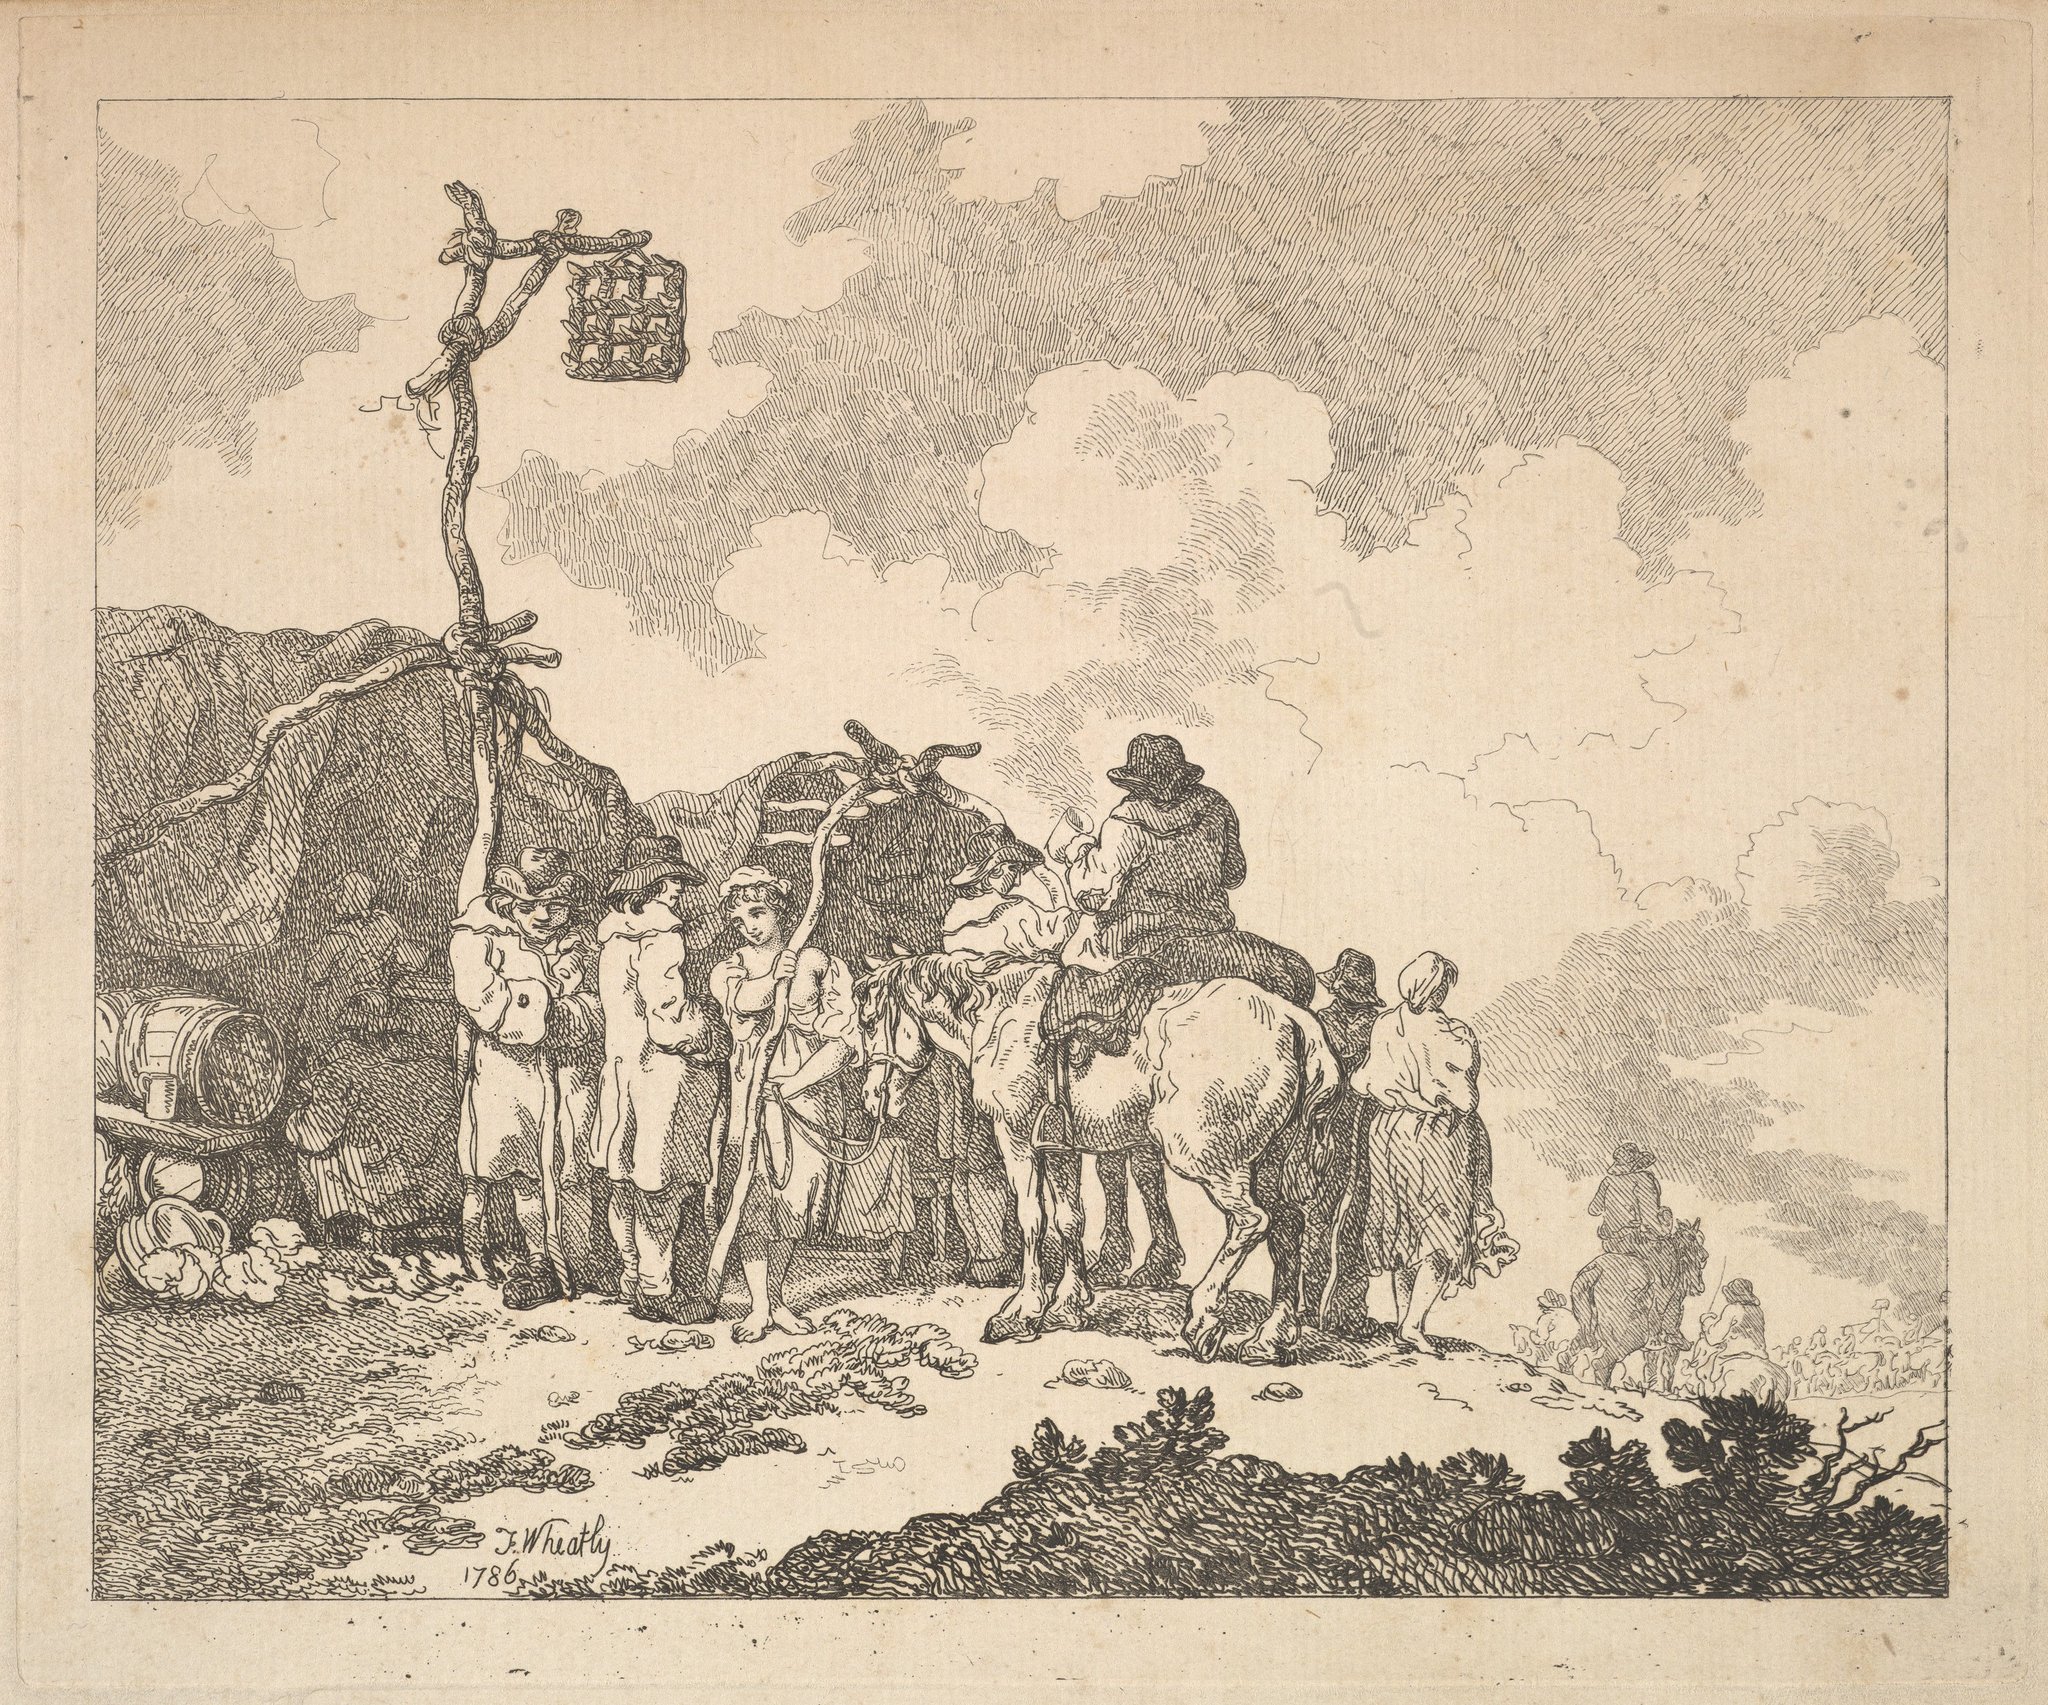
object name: print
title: A Fair – A Group of Gypsies – Men and Women in Rustic Clothes in Front of Two Makeshift Tents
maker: thomas rowlandson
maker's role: artist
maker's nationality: british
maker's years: 1757-1827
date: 1786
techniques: etching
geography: england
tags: tents,men,women,horses